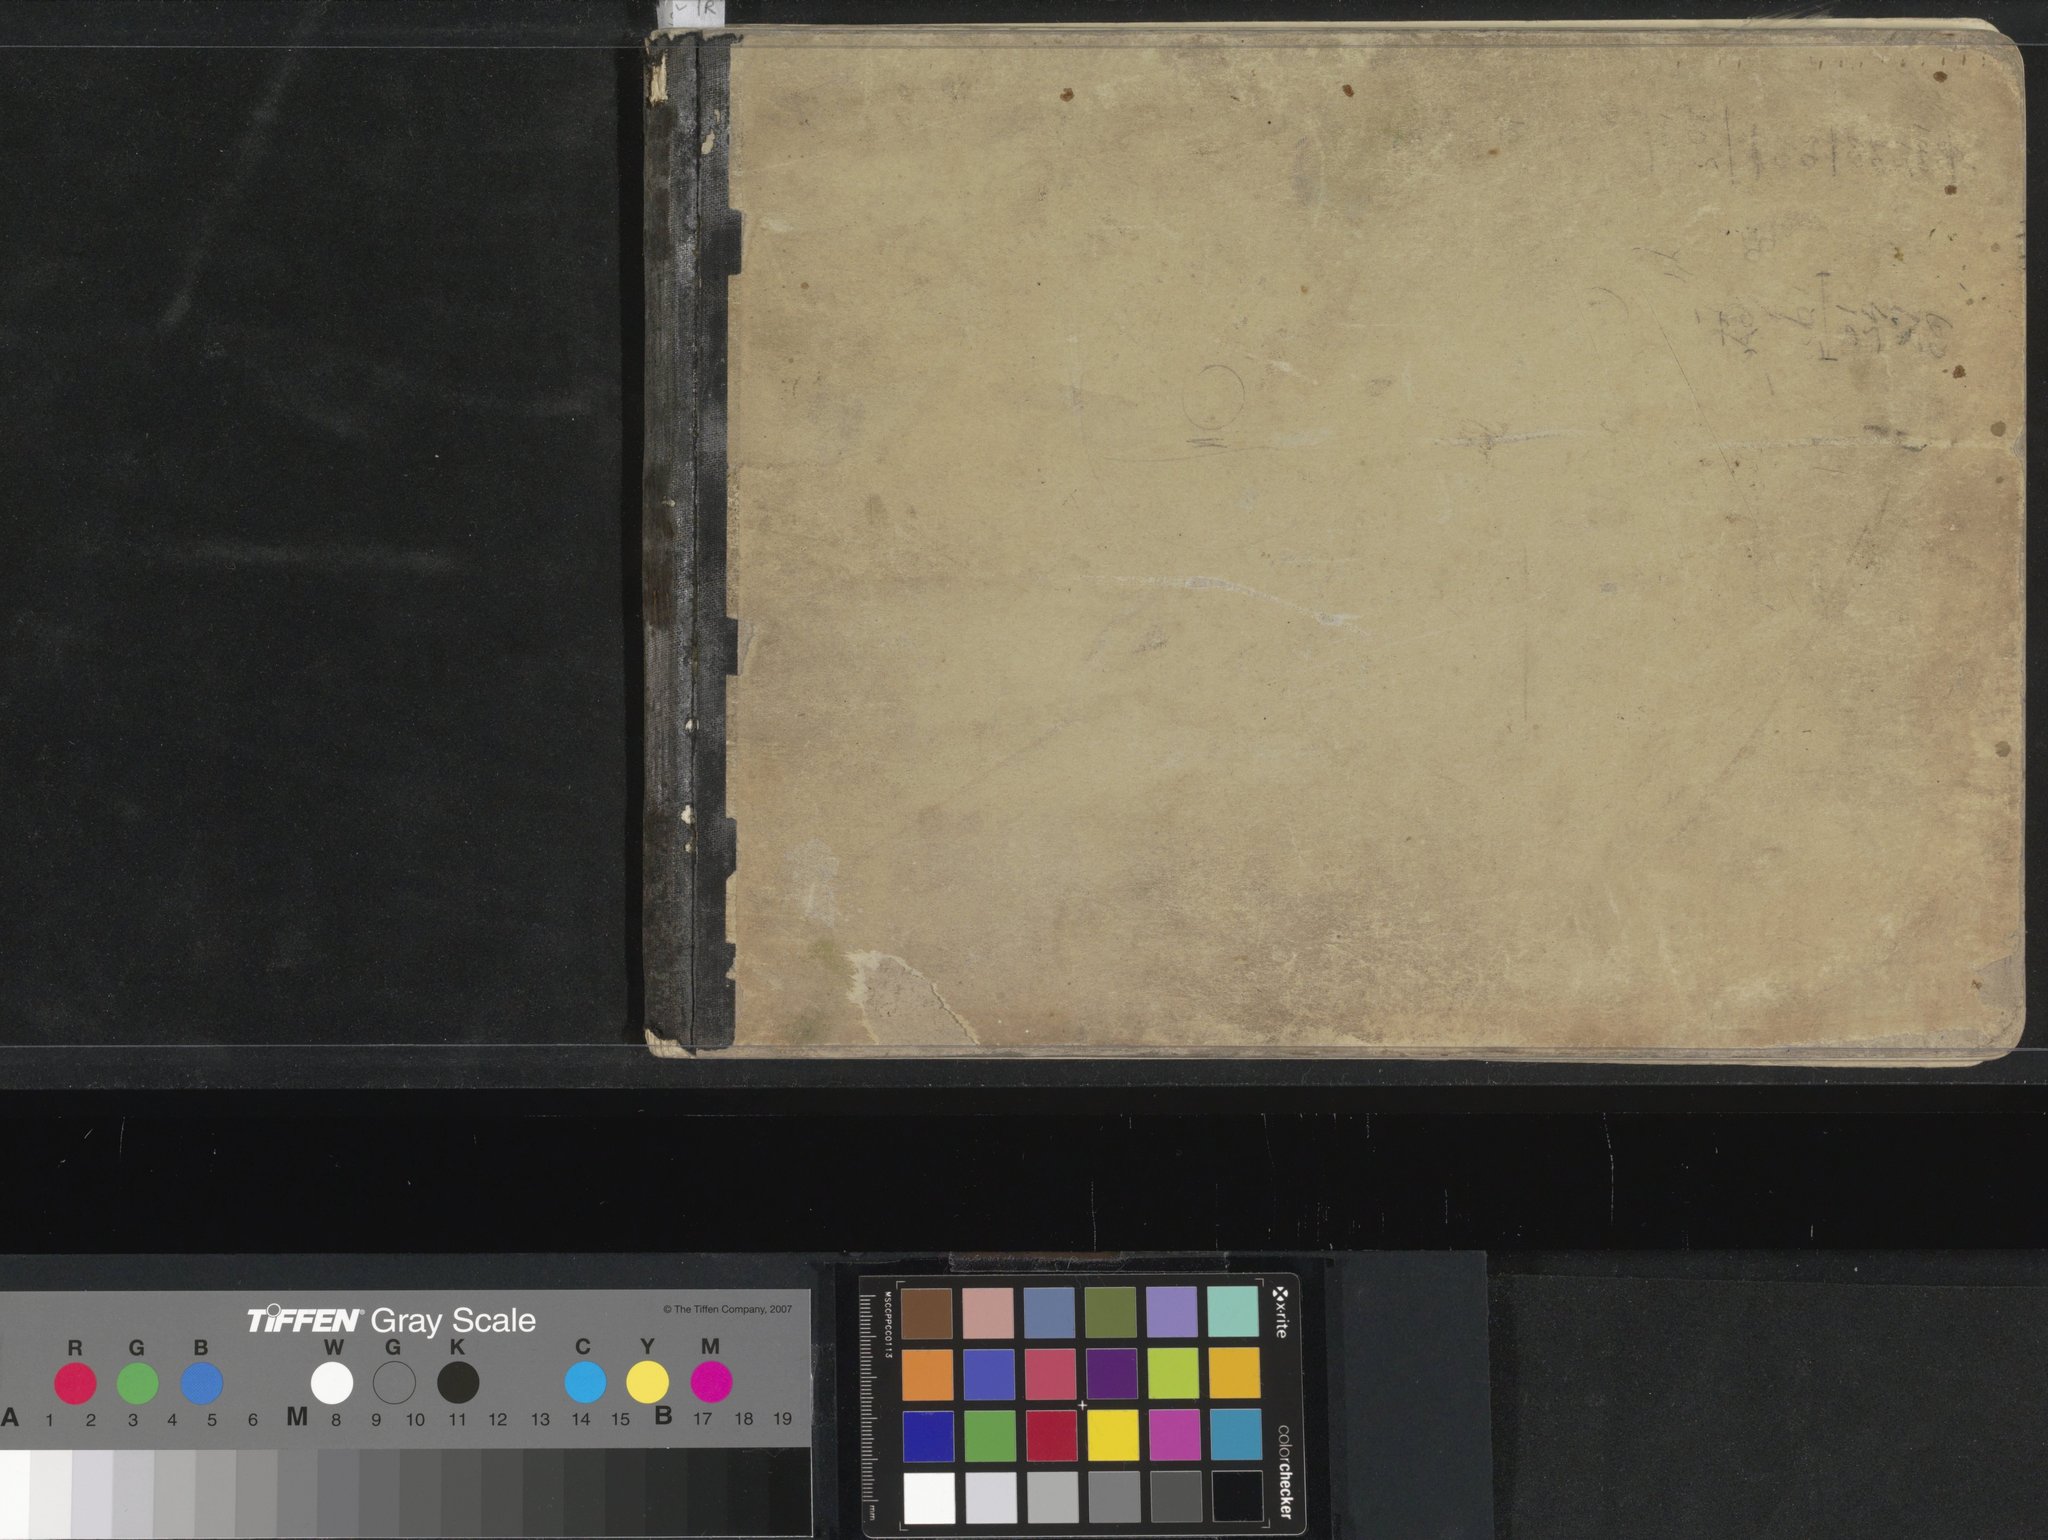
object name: sketchbook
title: Schetsboek met 23 bladen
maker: cornelis vreedenburgh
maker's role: draughtsman, print maker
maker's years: 1880-1946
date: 1890-1946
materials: cardboard, chalk, ink, linen, paper, pencil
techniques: pen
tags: landscapes, animals, anatomy (non-medical)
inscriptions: retailer's mark: ‘J.H. VAN [...]K/ Spec[...]/ Jacob van Campenstraat 68[...]/ AMSTERDAM’, collector's mark: Lugt 2228a, annotation: ‘[...]’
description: Schetsboek bestaande uit 23 bladen met voornamelijk landschappen, dieren en figuurstudies. Op de achterzijde van de boekband een studie van een kop van een kind.